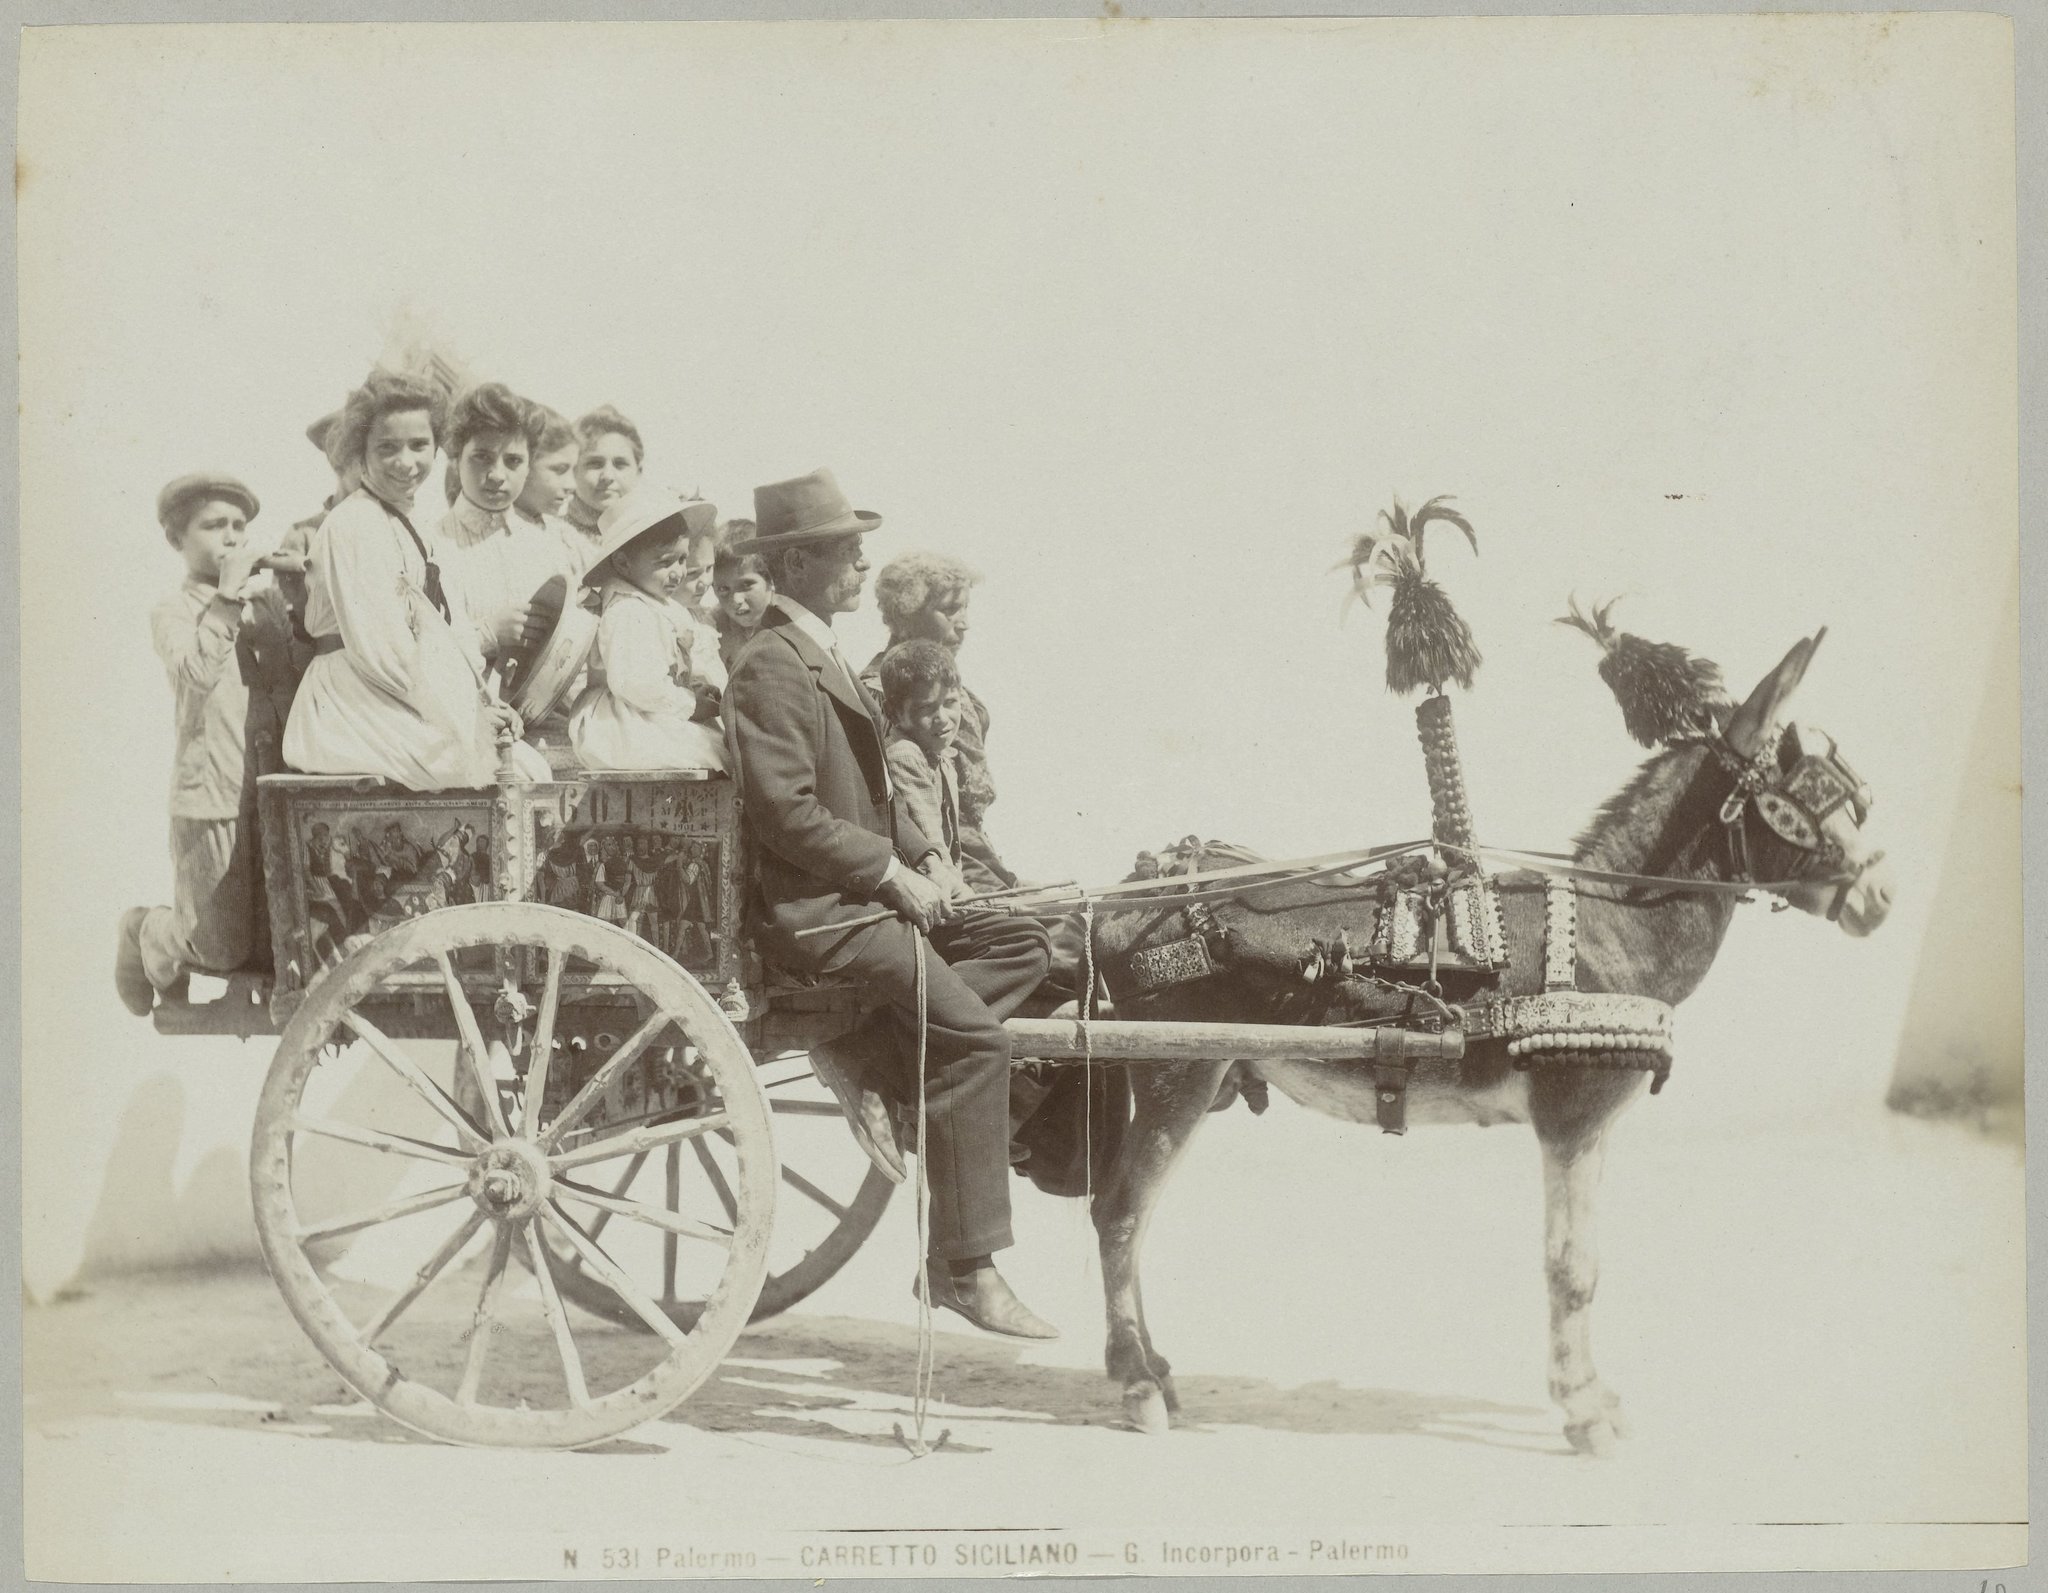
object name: photograph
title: N 531 palermo Carretto Siciliano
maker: giuseppe incorpora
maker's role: fotograaf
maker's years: 1834-1914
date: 1893-1903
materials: cardboard, photographic support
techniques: albumen print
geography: netherlands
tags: palermo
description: Een bewerkte en beschilderde ezelkar beladen met mensen.